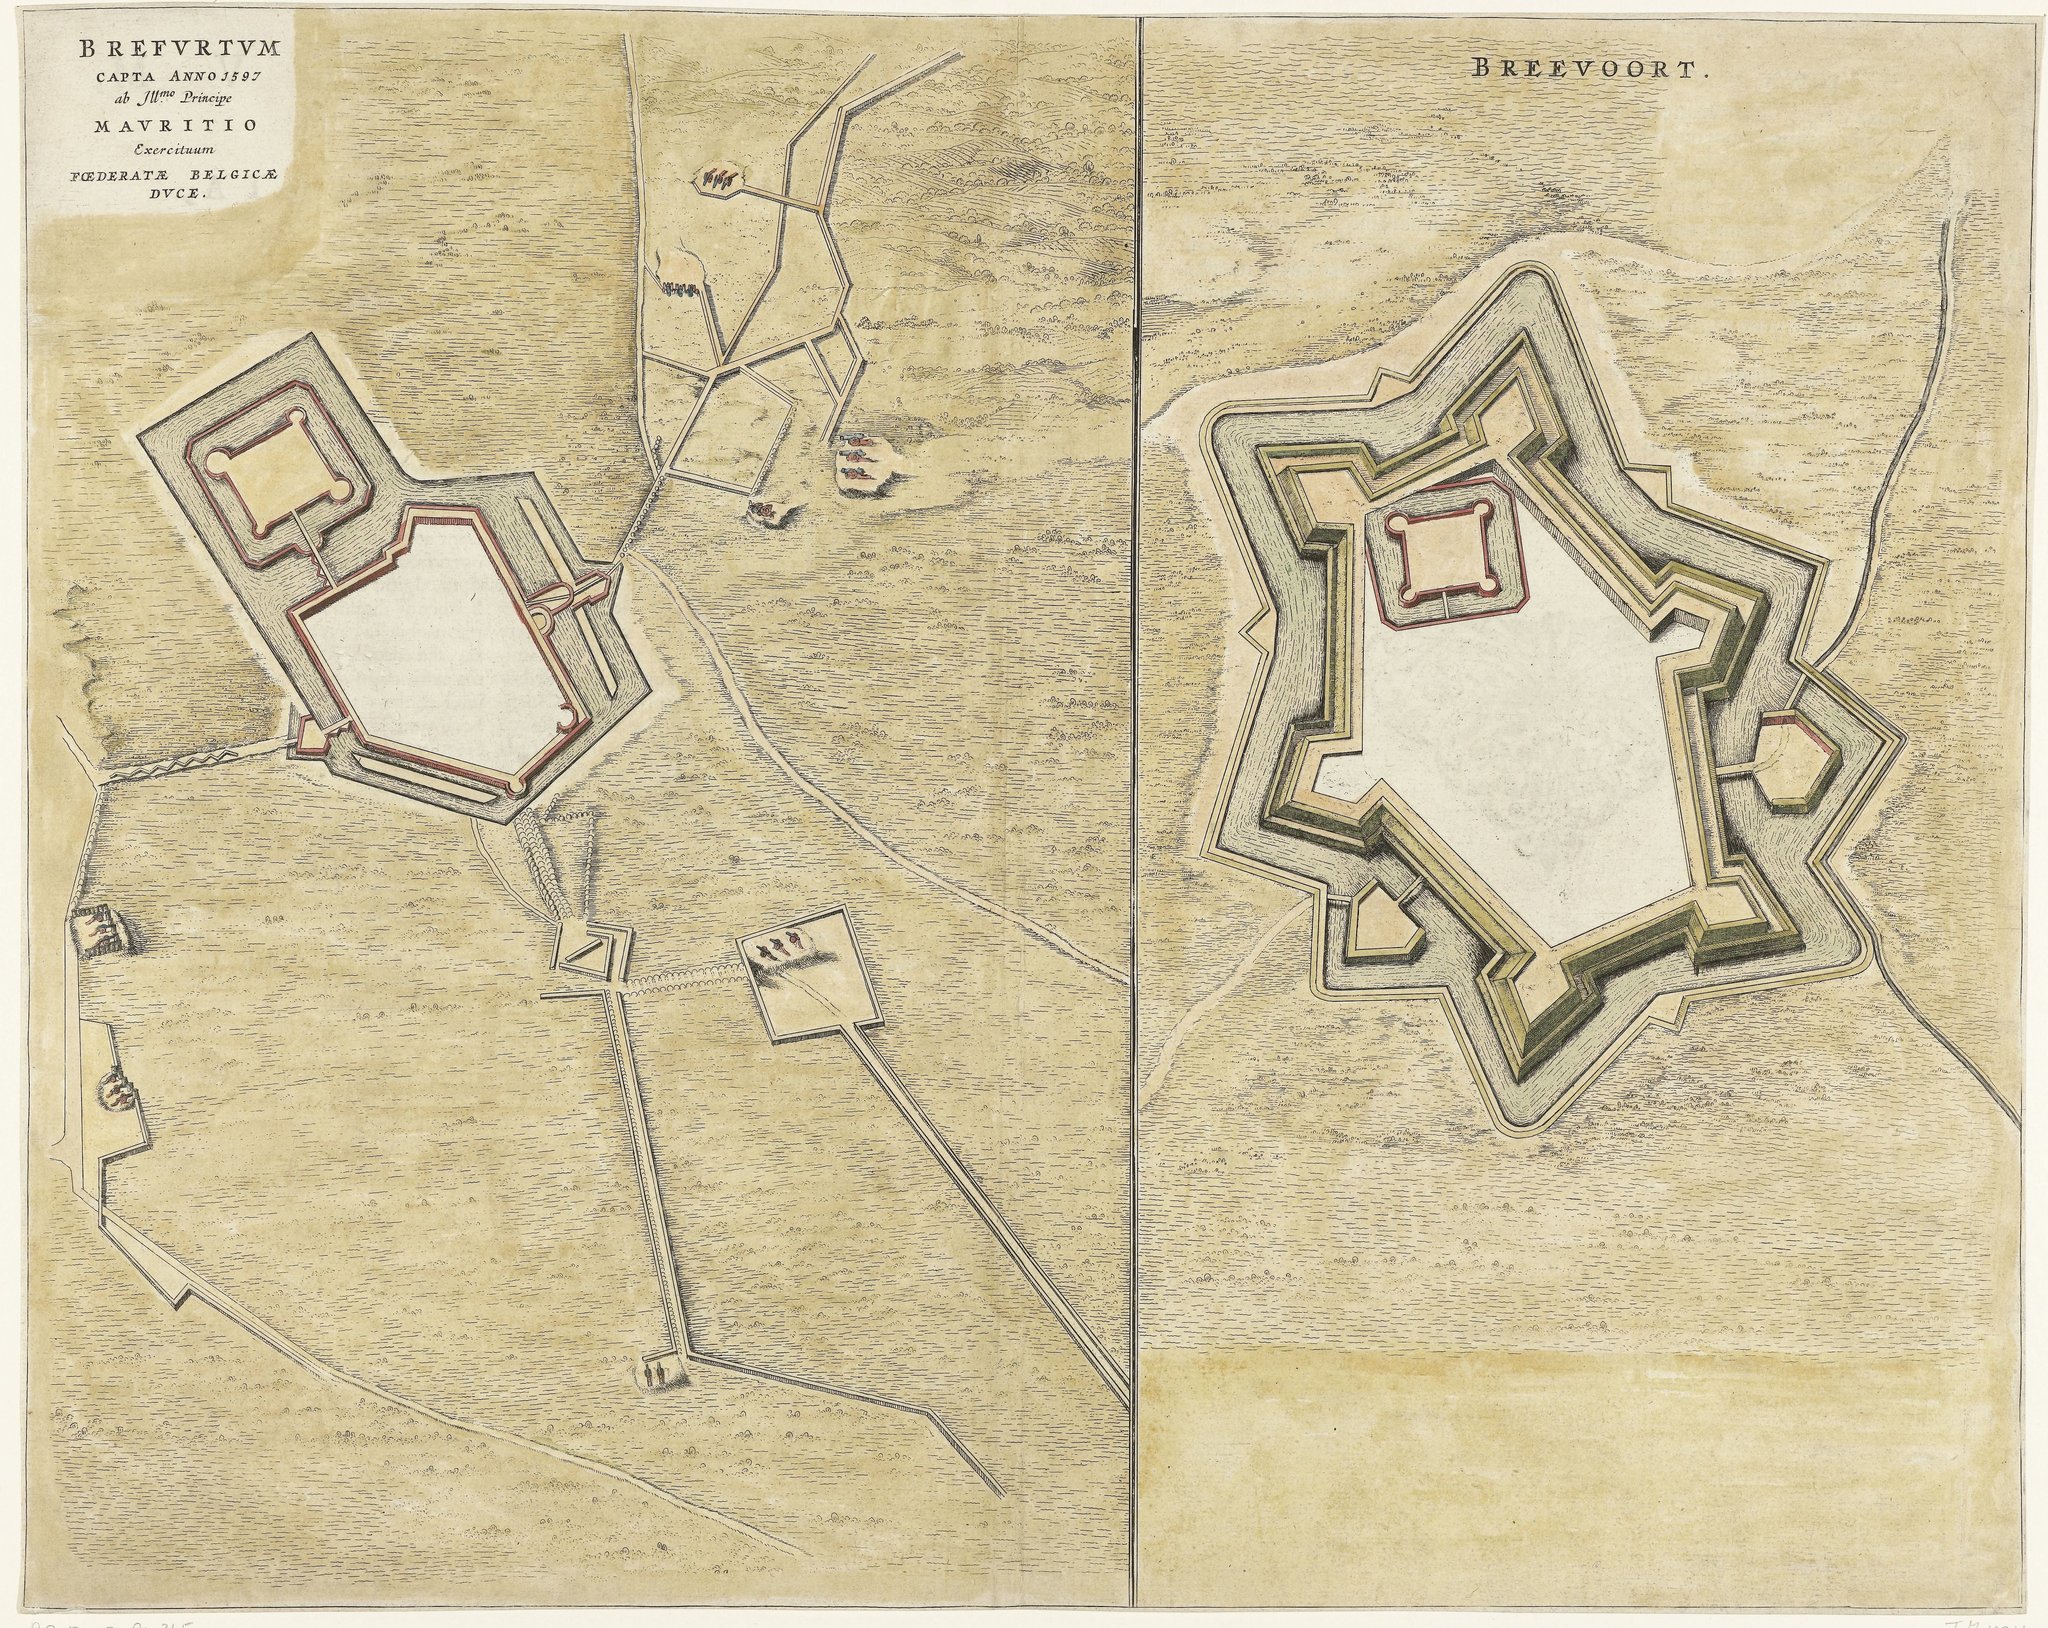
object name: history print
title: Plattegrond van de stad en het kasteel van Bredevoort met de versterkingen, 1597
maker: Anonymous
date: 1647-1649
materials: paper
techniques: etching, hand coloring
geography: northern netherlands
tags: the hague, maurice (prince of orange), capture of city (after the siege), maps of cities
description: Ingekleurde plattegrond van de stad stad en het kasteel van Bredevoort met de versterkingen, ten tijde van de verovering door het Staatse leger onder prins Maurits, 12 oktober 1597. Dubbel gevouwen blad bedrukt op achterzijde met tekst in het Latijn.